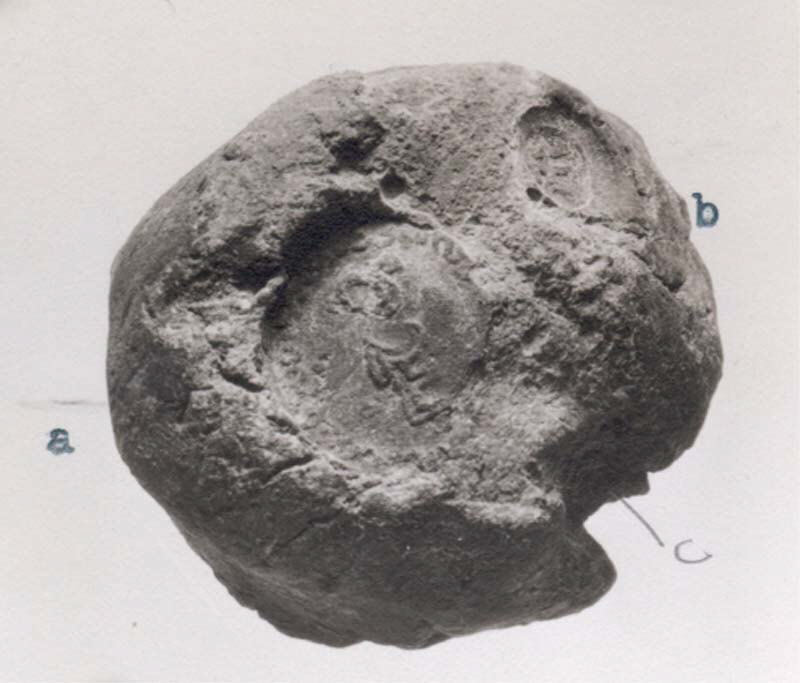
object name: sealing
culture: sasanian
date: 601-700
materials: clay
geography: iran